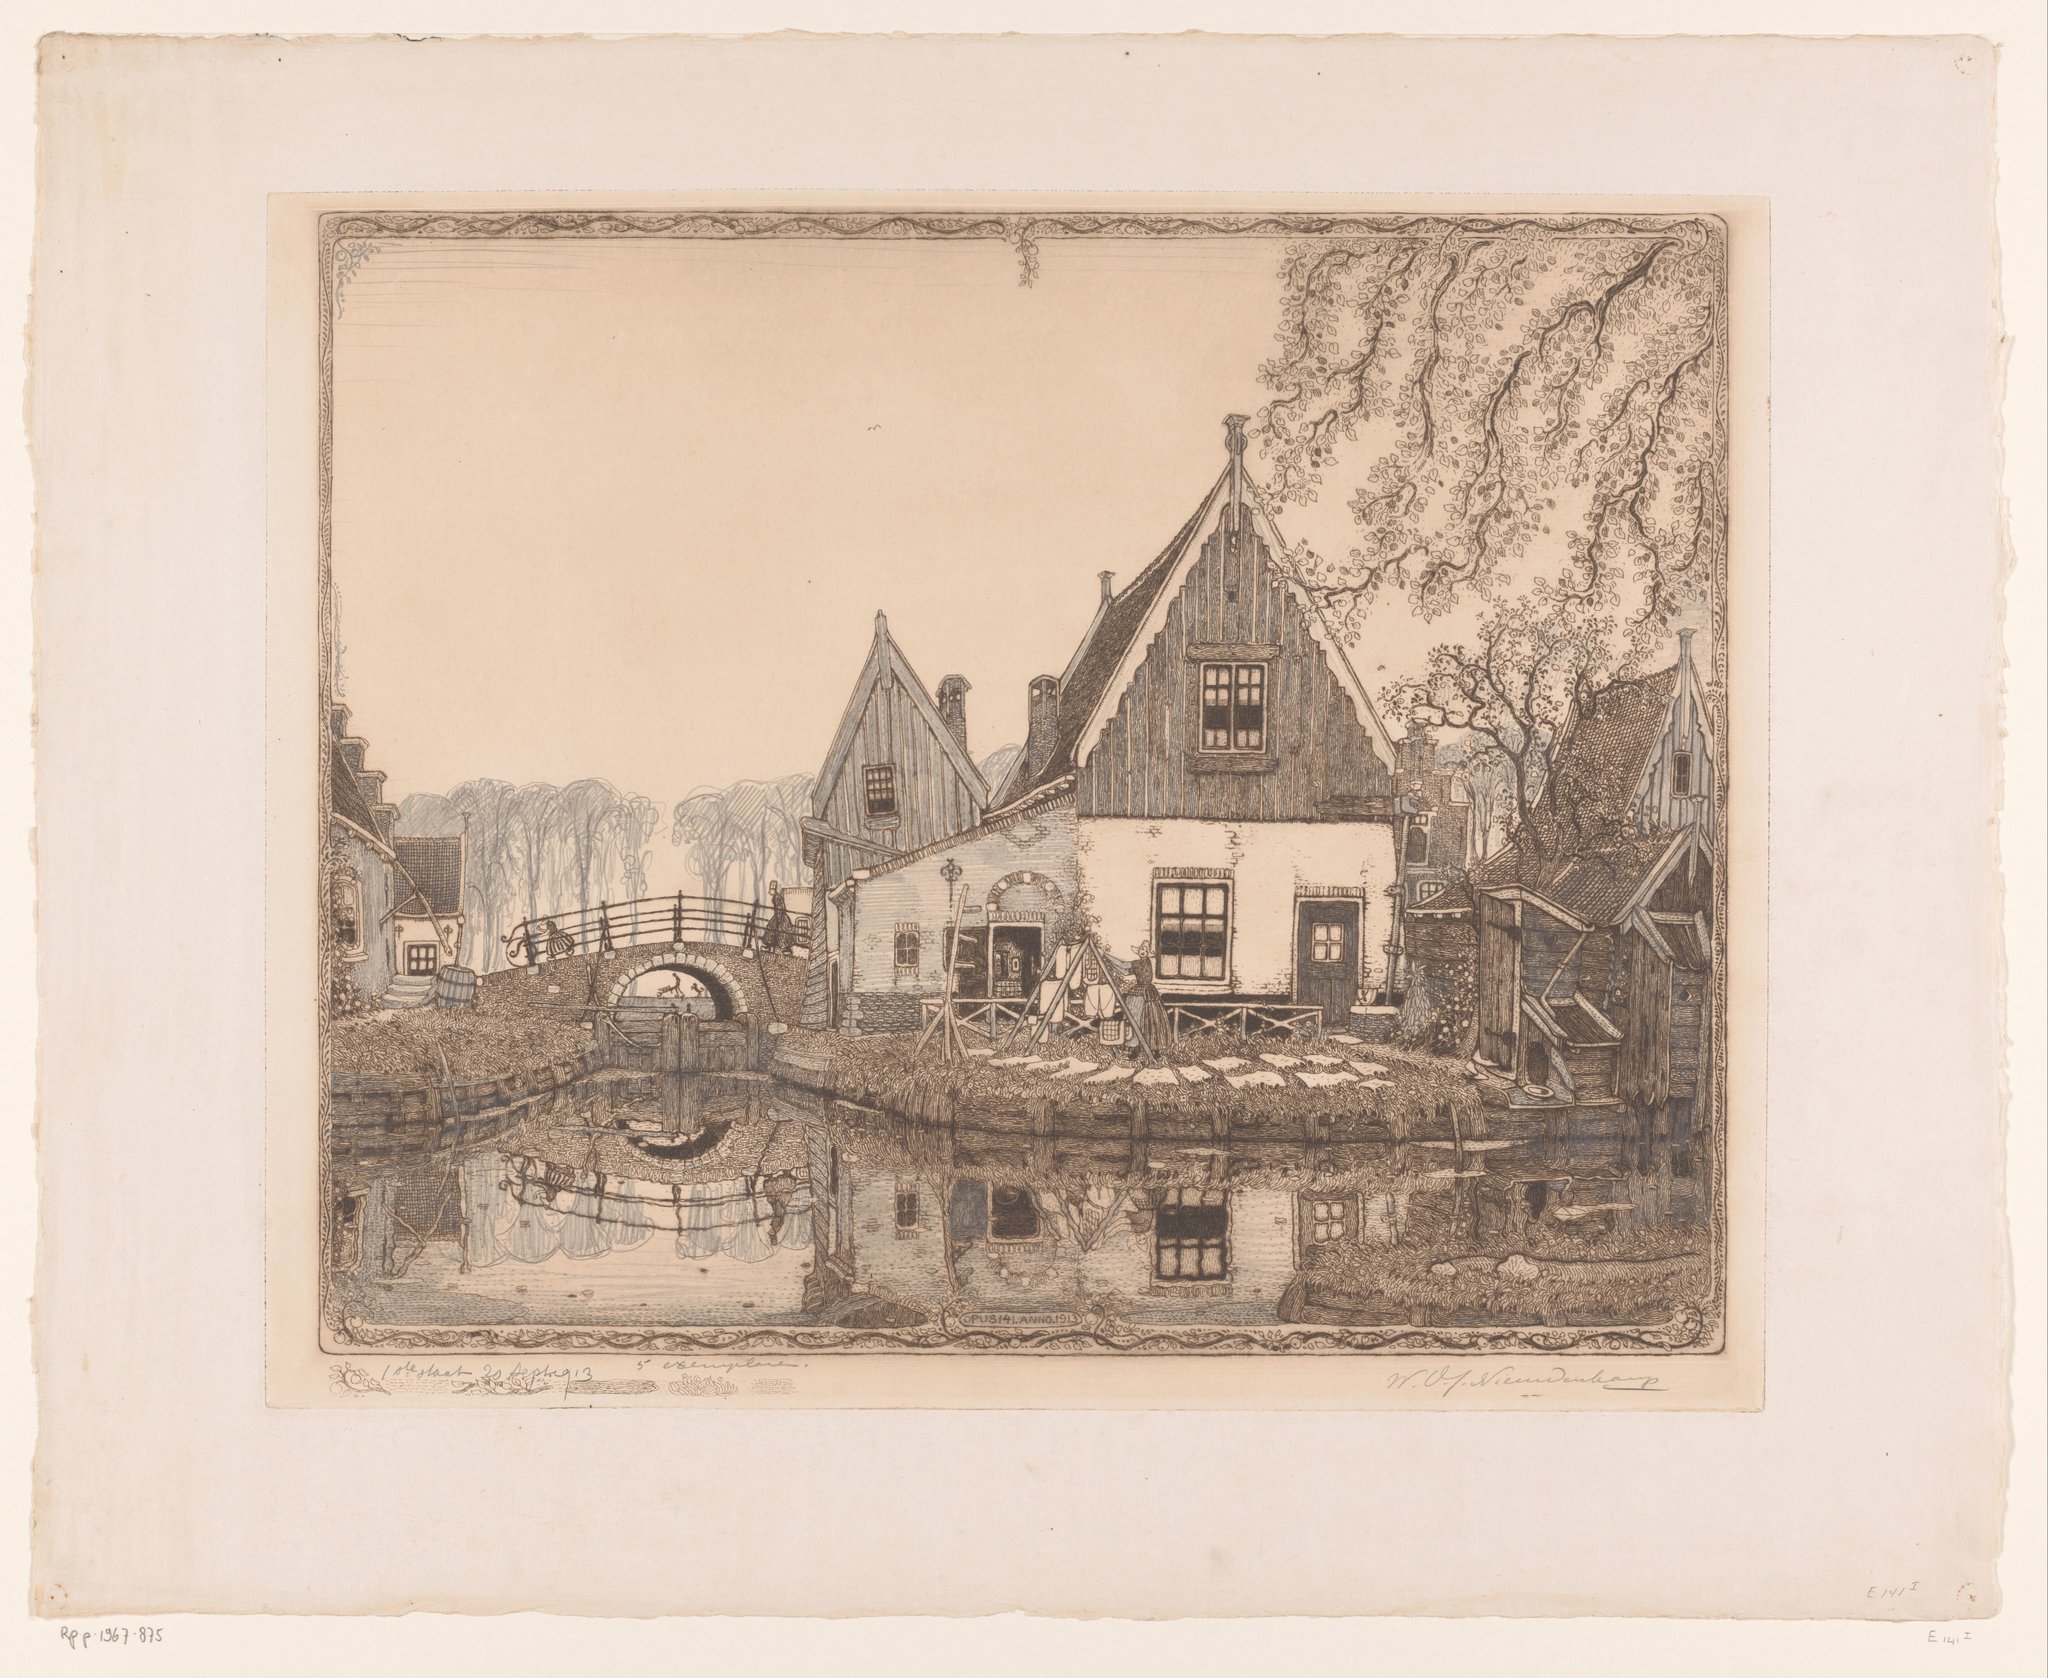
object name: print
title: Het aardige sluisje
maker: wijnand otto jan nieuwenkamp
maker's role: draughtsman, print maker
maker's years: 1874-1950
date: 1913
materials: paper, pencil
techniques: etching, intaglio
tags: village, lift-lock, canal lock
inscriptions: annotation: ‘5 exemplaren’, collector's mark: Lugt 2228, collector's mark: Lugt 2760